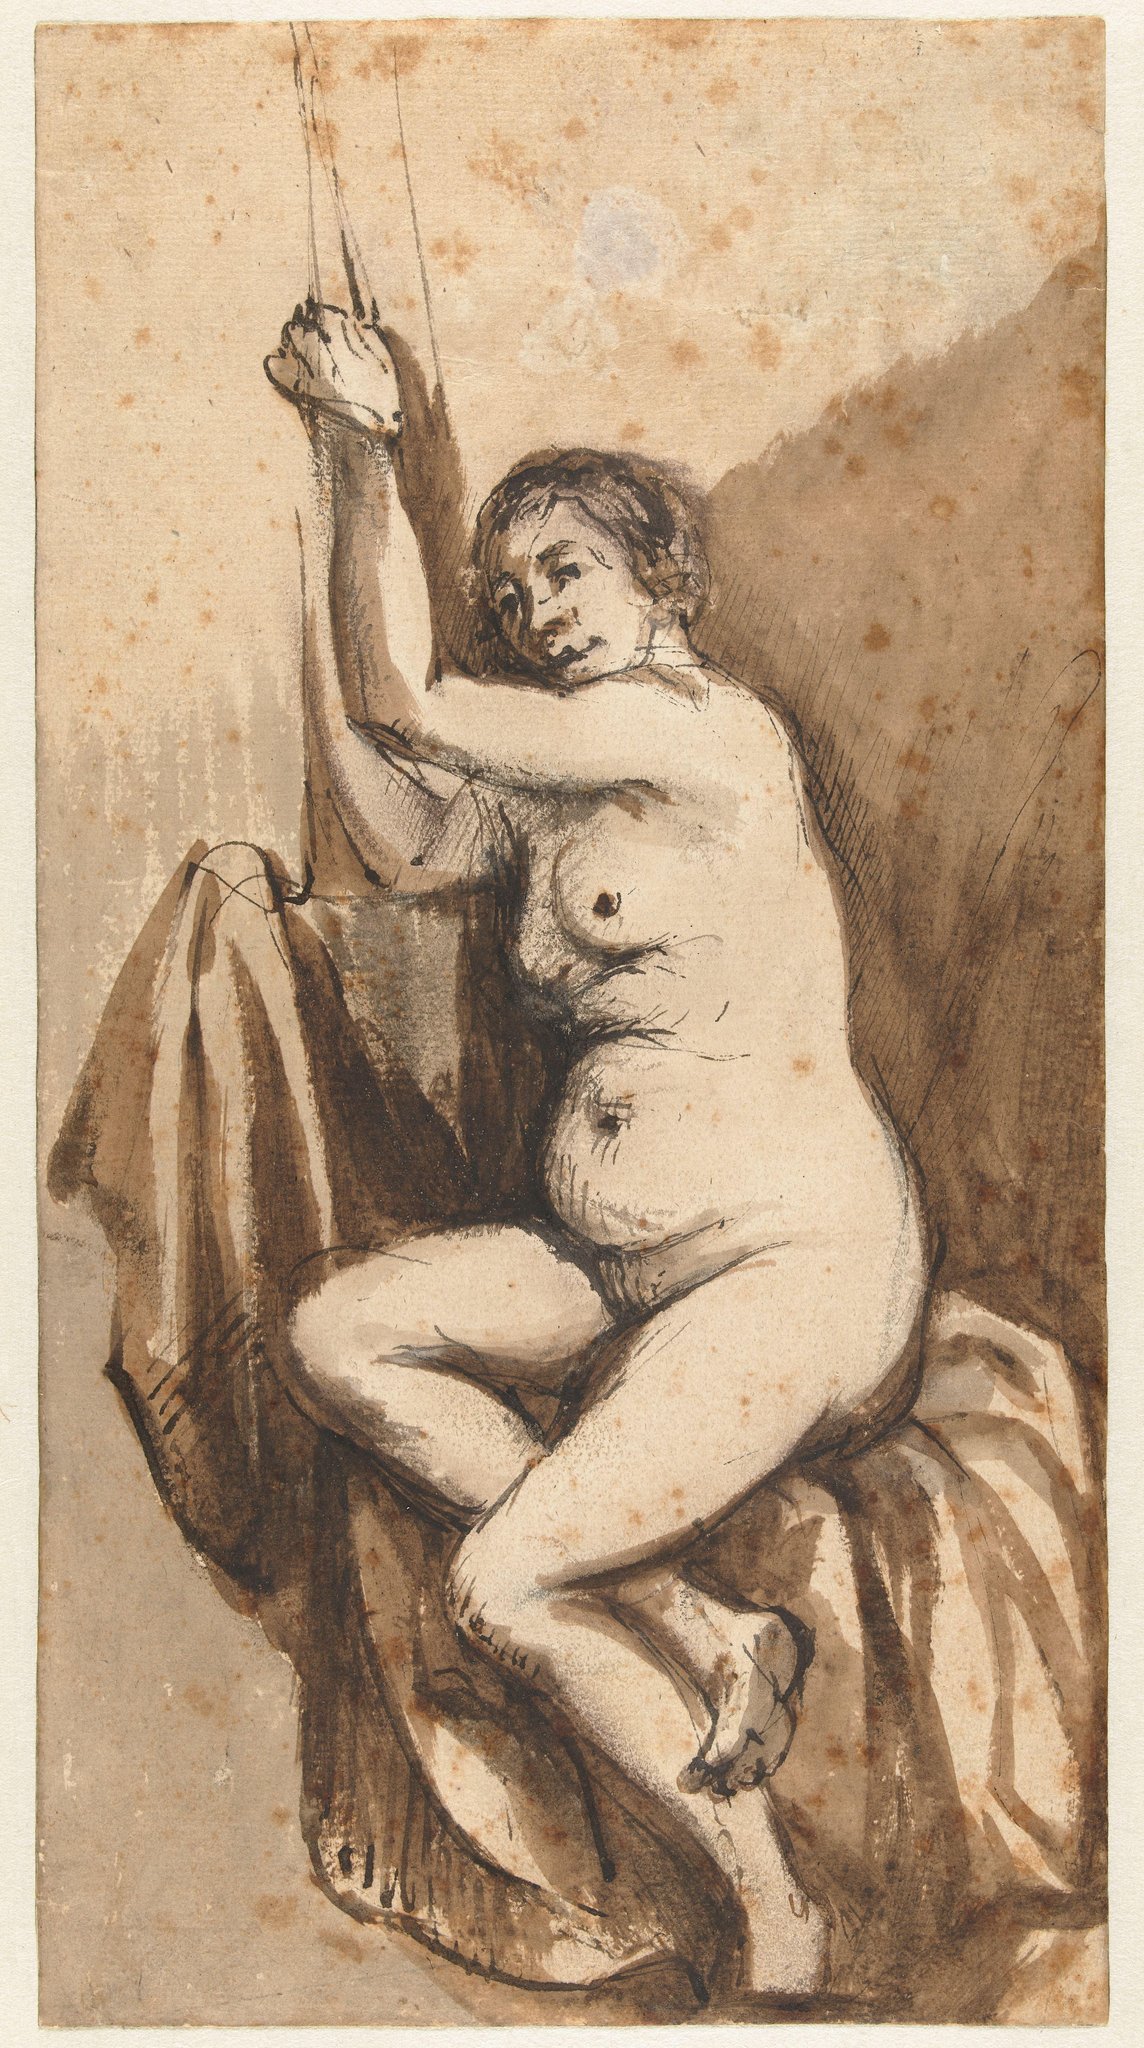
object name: drawing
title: Seated Female Nude with Raised Arms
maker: johannes raven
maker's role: draughtsman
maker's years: 1633-1662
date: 1658-1662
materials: ink, paper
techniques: brush, pen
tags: sitting figure - aa - female human figure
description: A number of studies of nudes by Johannes Raven made in Rembrandt’s workshop are known. The model who posed for this drawing session can also be recognized in other sketches by him. In the 17th century, posing nude was considered improper for women and those who did so could even be arrested. Accordingly, it was something almost only prostitutes were willing to do.